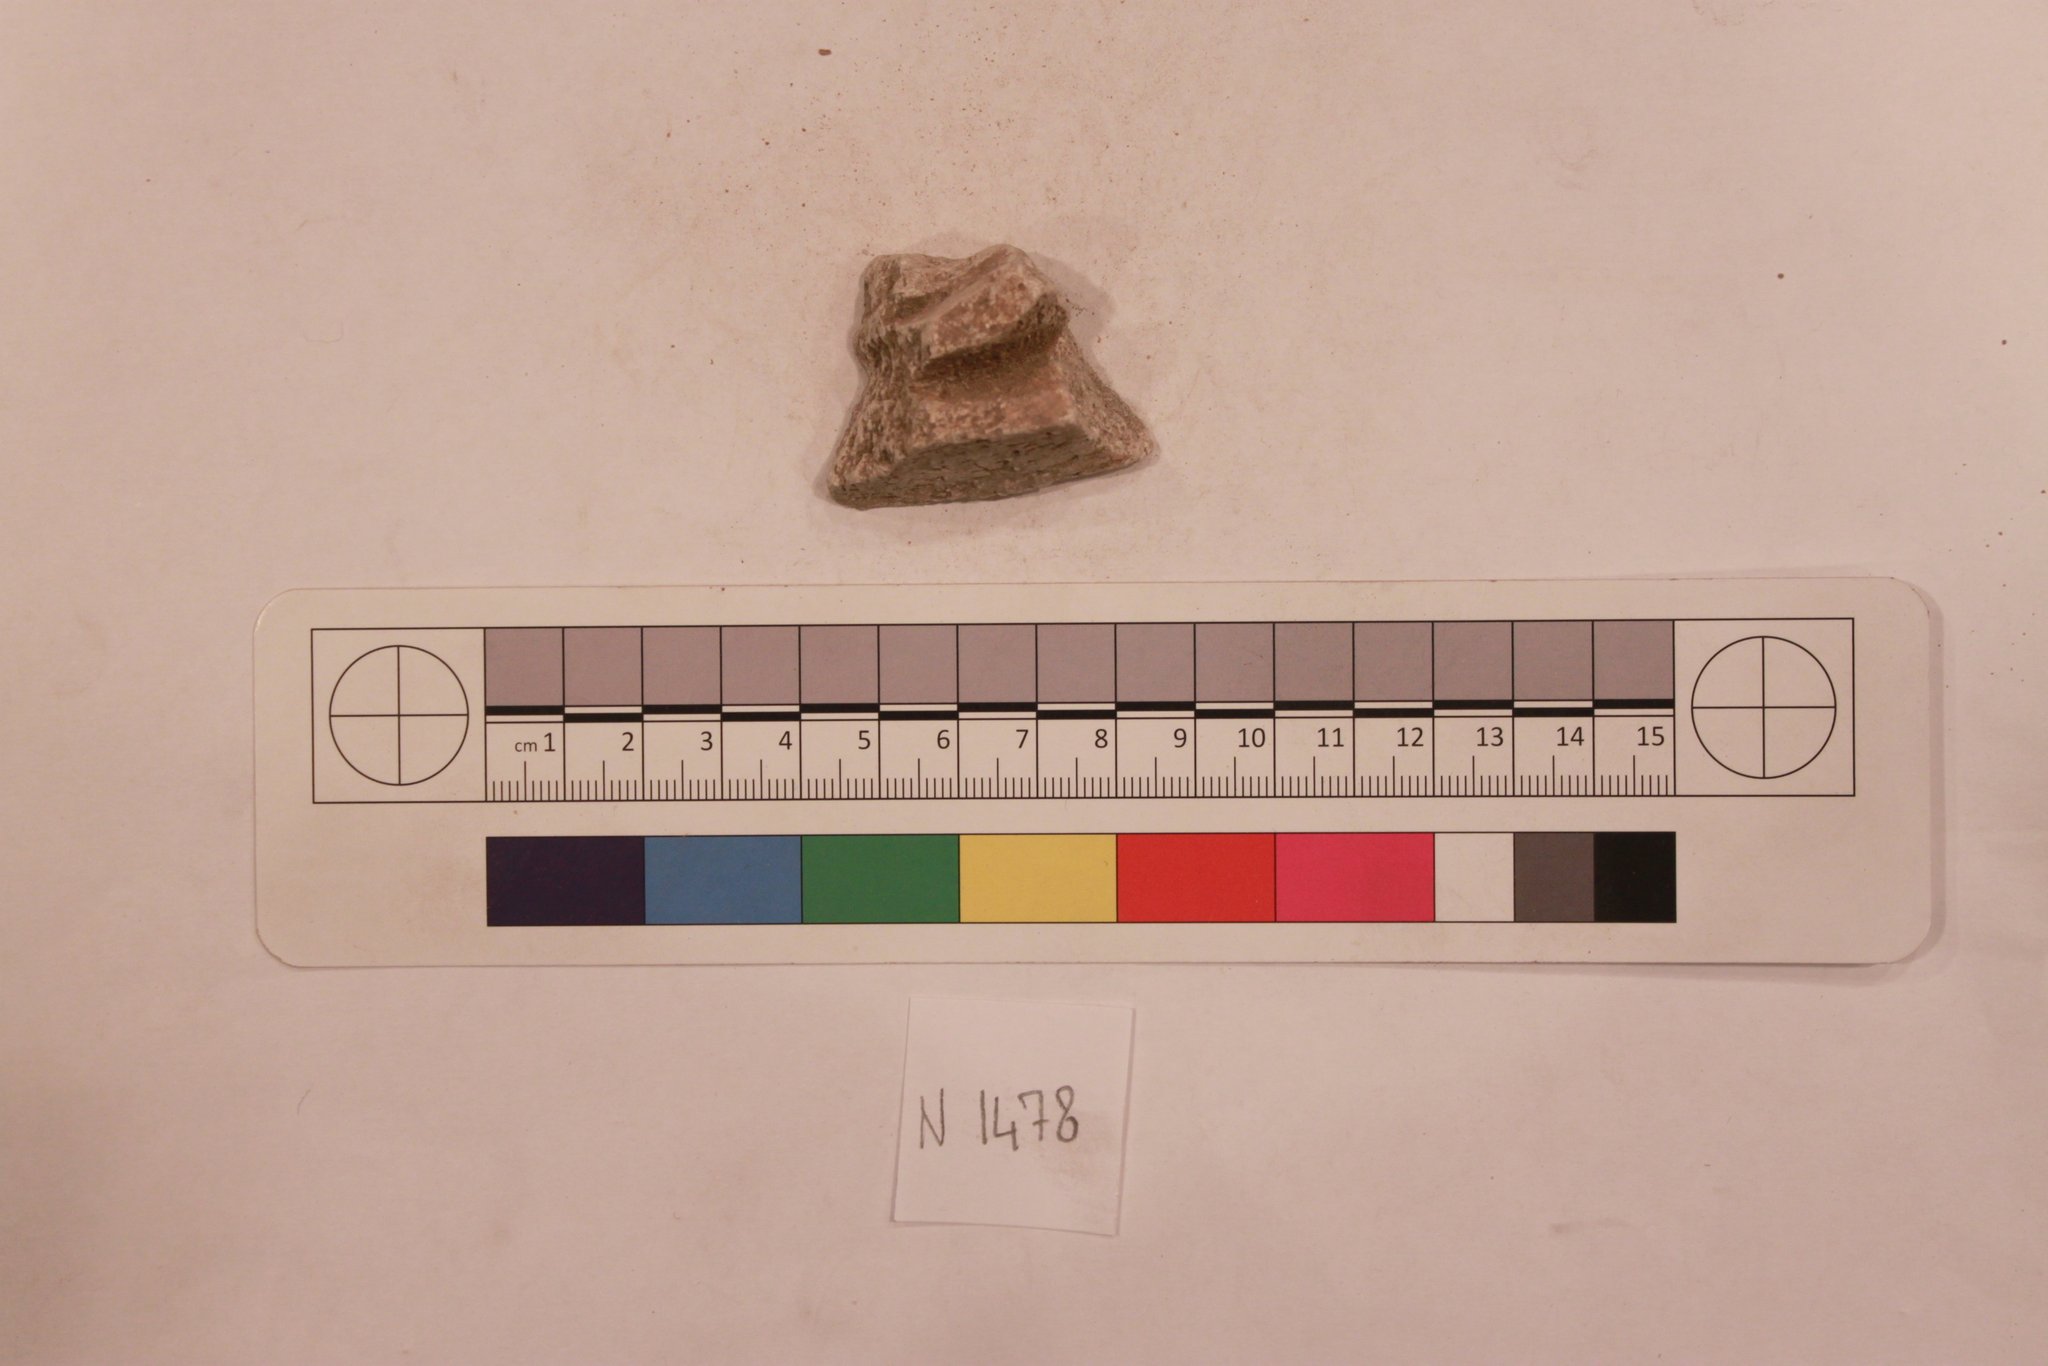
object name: fragment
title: Stucco Fragment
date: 701-1200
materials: plaster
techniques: carving, painting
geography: iran